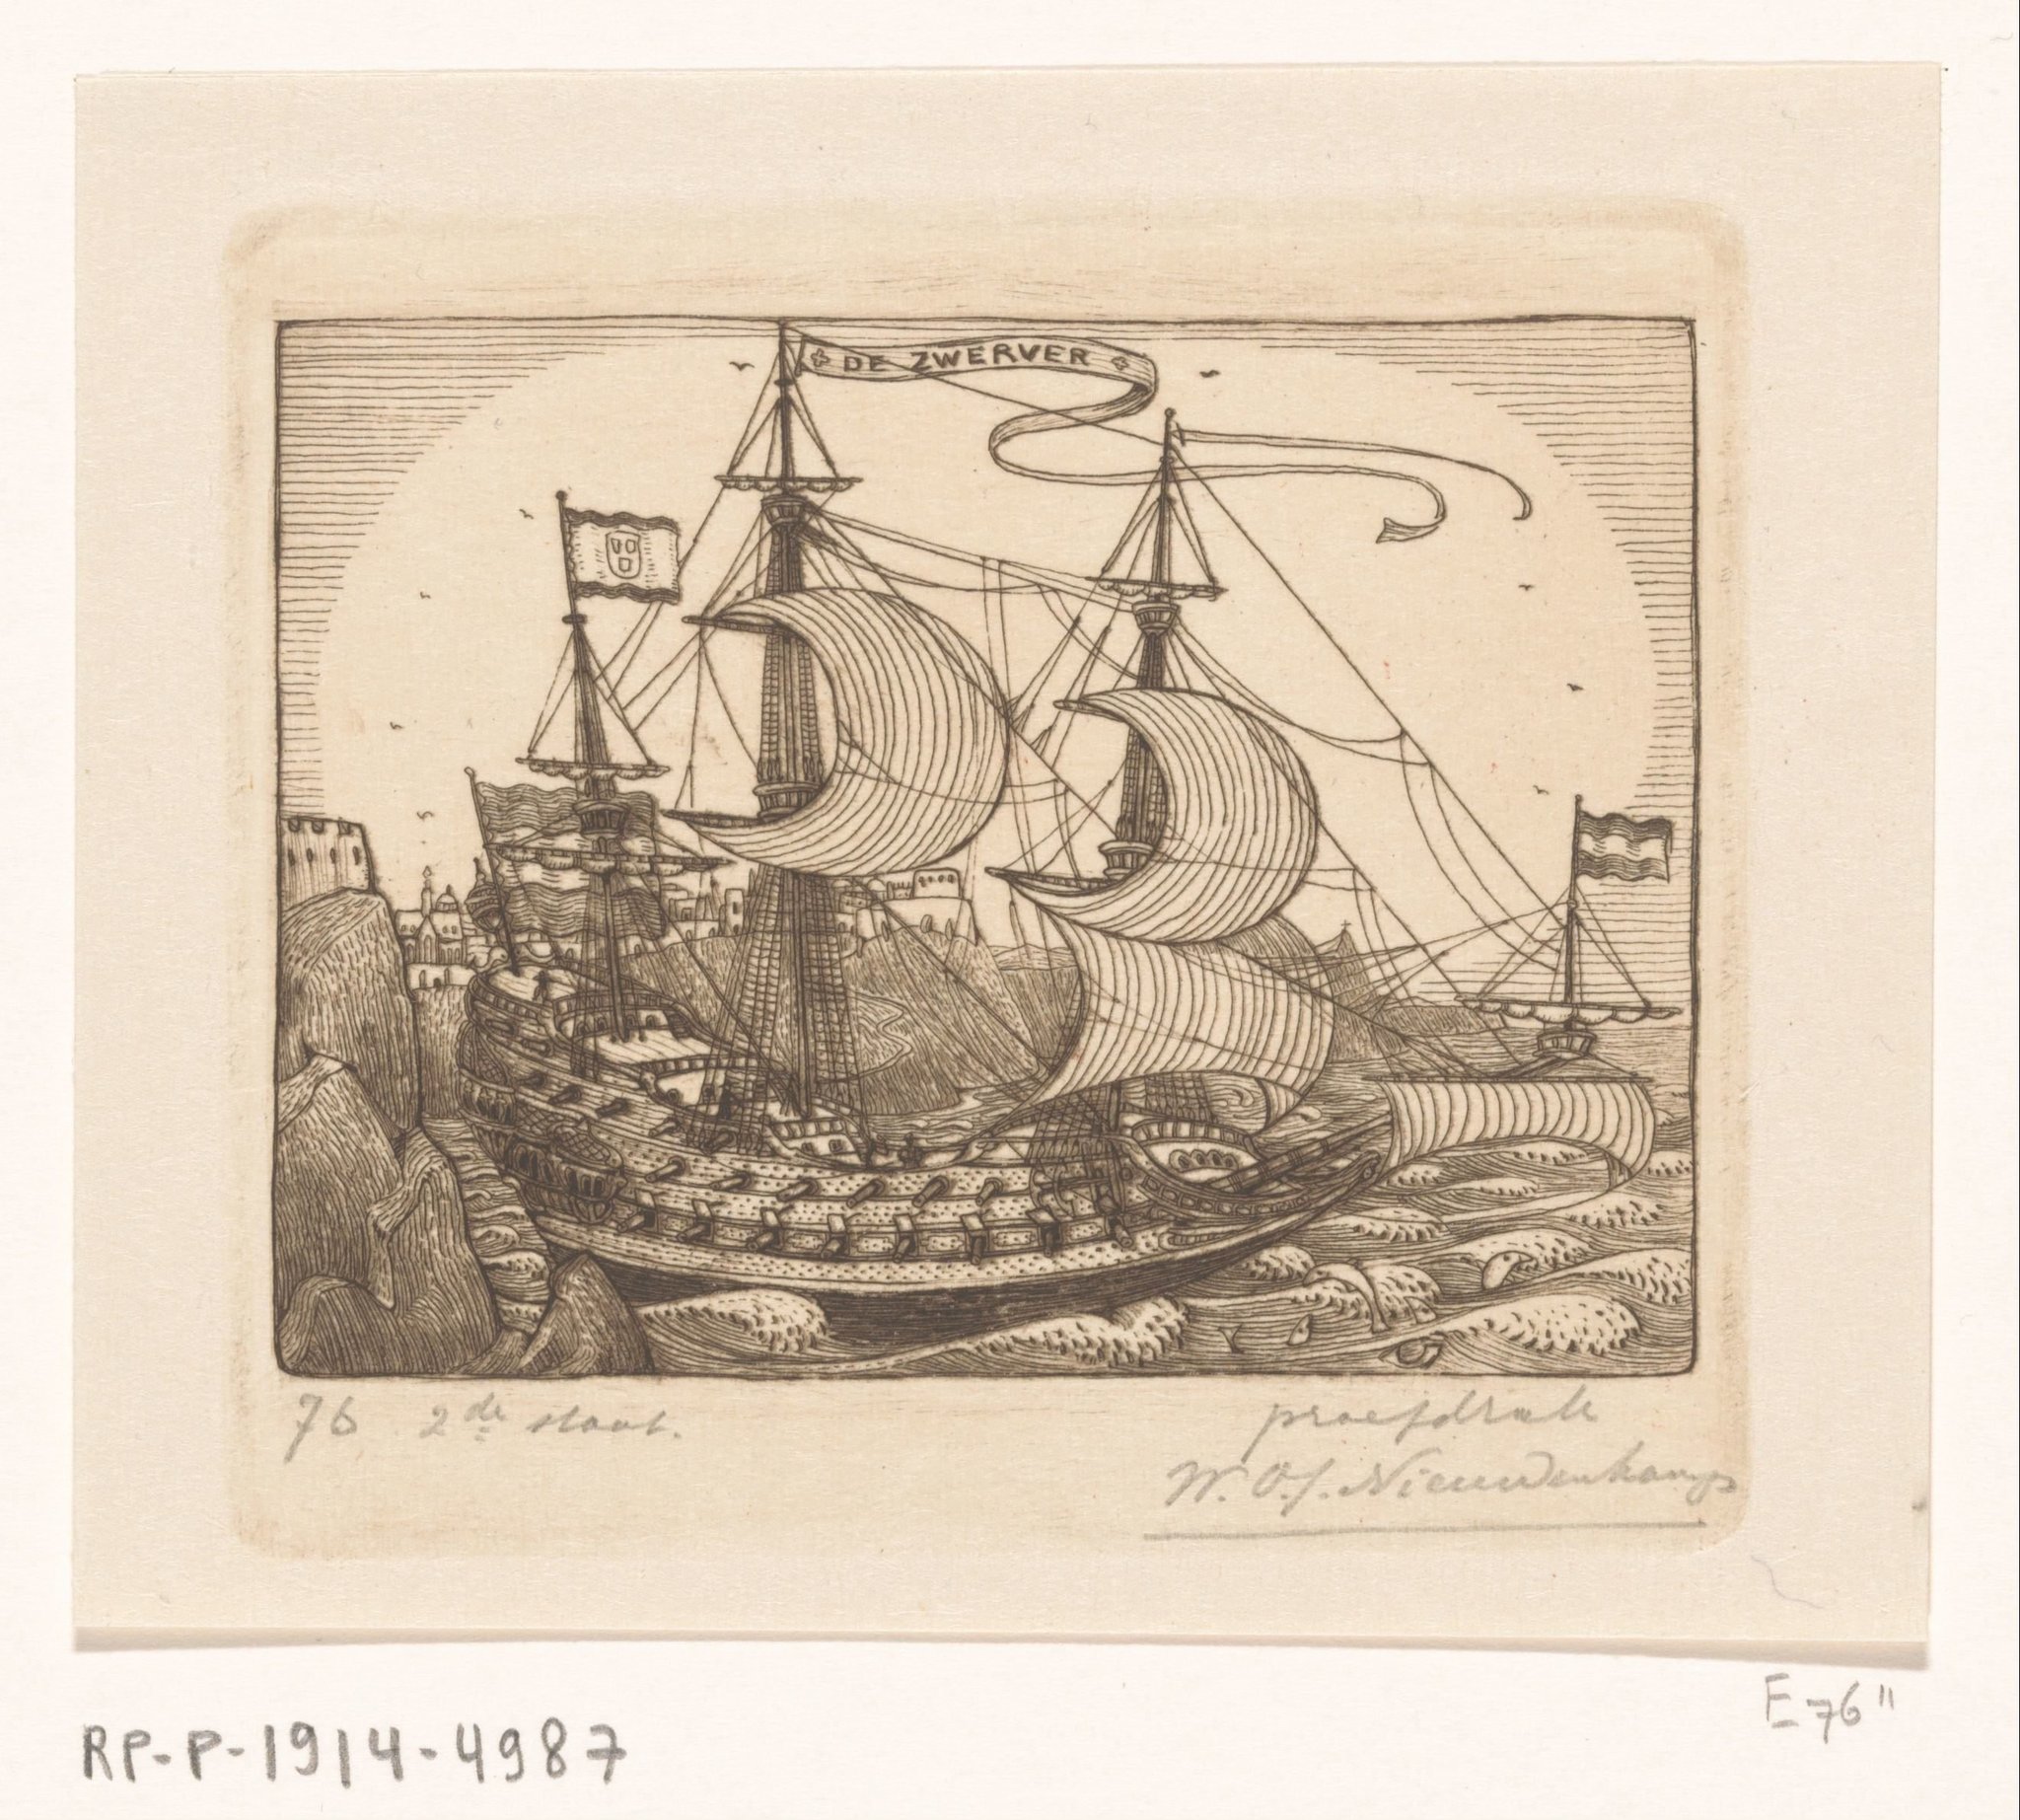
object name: business card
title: Adreskaart van Wijnand Otto Jan Nieuwenkamp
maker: wijnand otto jan nieuwenkamp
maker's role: draughtsman, print maker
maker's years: 1874-1950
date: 1903-1907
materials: paper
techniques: etching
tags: amsterdam, print maker, draughtsman, wijnand otto jan nieuwenkamp, sailing-ship, sailing-boat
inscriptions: collector's mark: Lugt 2233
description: Een driemaster die een haven verlaat. Op de wimpel aan de hoogste mast staat 'De Zwerver', de naam van de woon- en atelierboot die Nieuwenkamp ontwierp en bouwde.